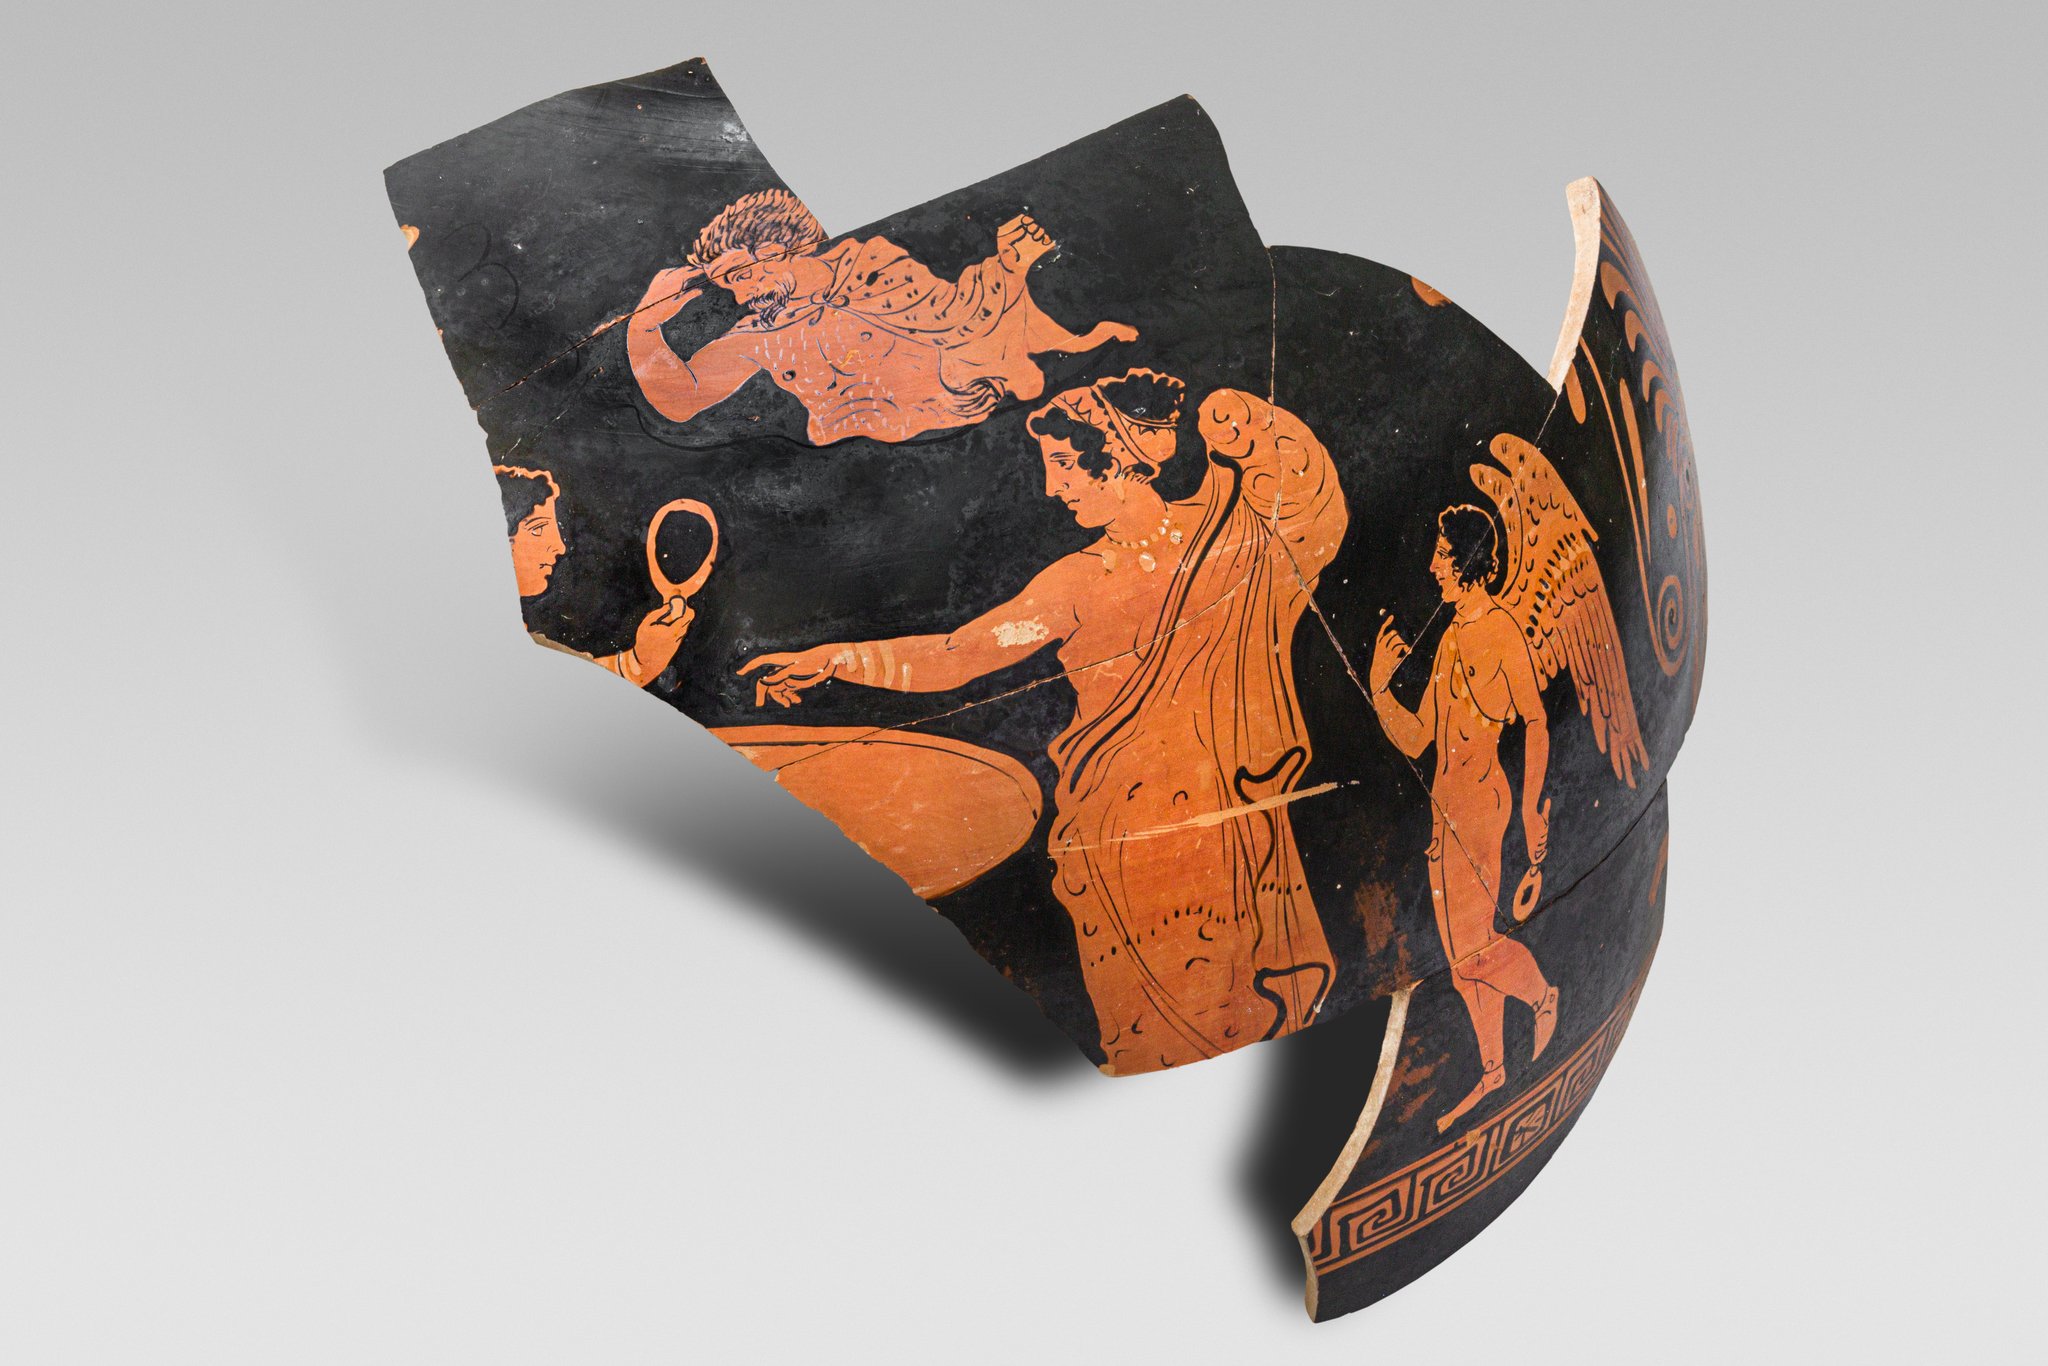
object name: hydria fragment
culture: greek, south italian, lucanian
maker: hamburg painter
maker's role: artist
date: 410-380 BCE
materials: terracotta